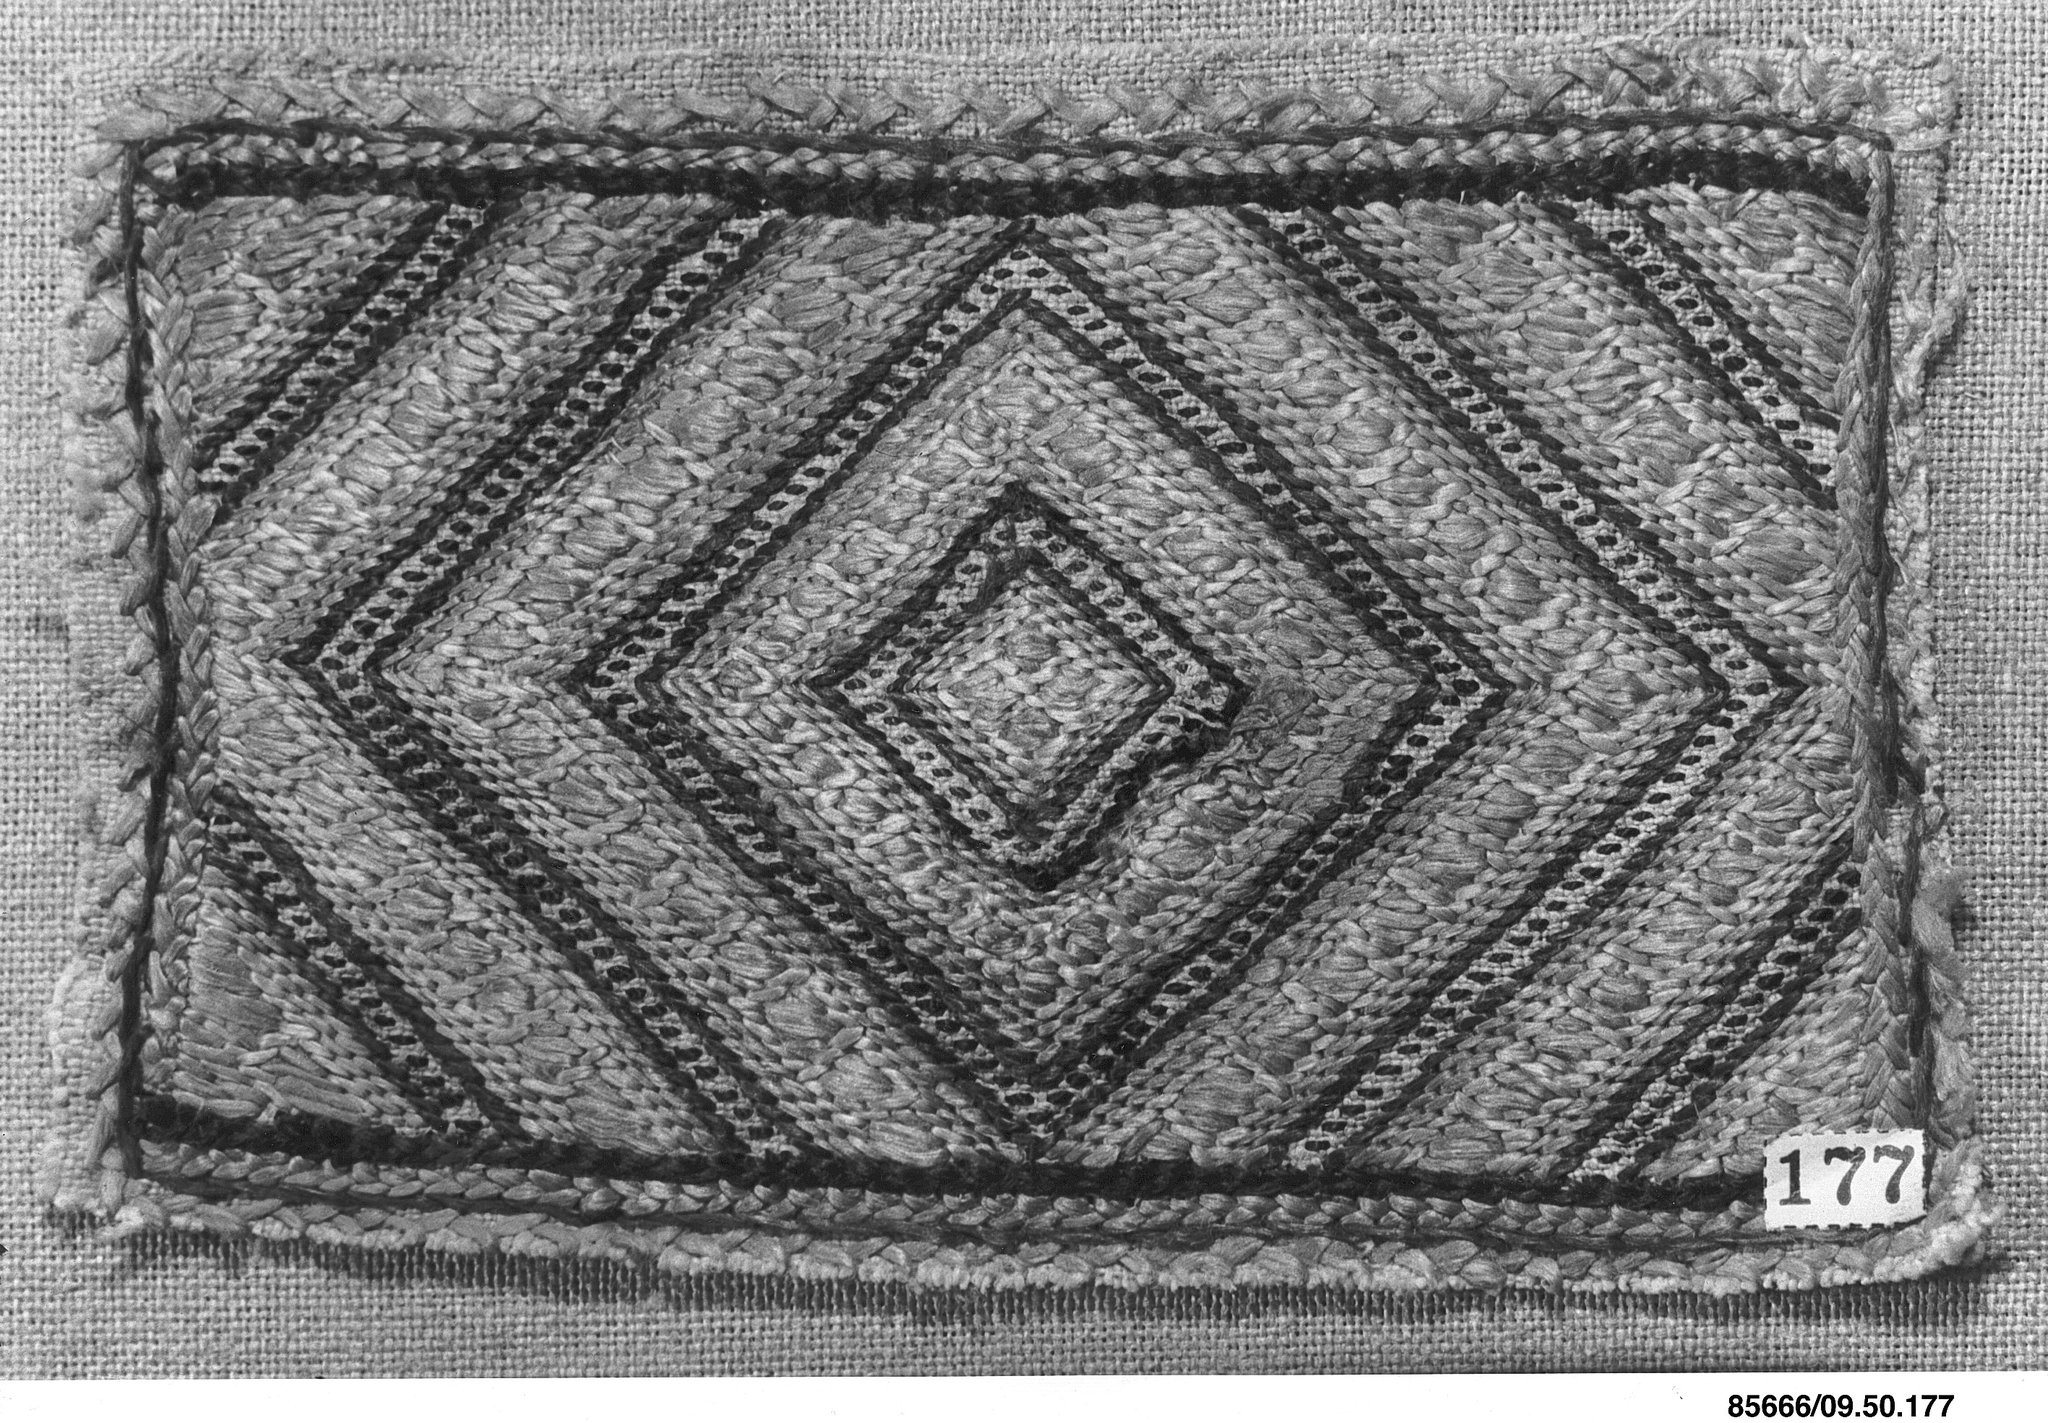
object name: costume fragment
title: Peasant costume fragment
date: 1701-1900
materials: canvas, silk